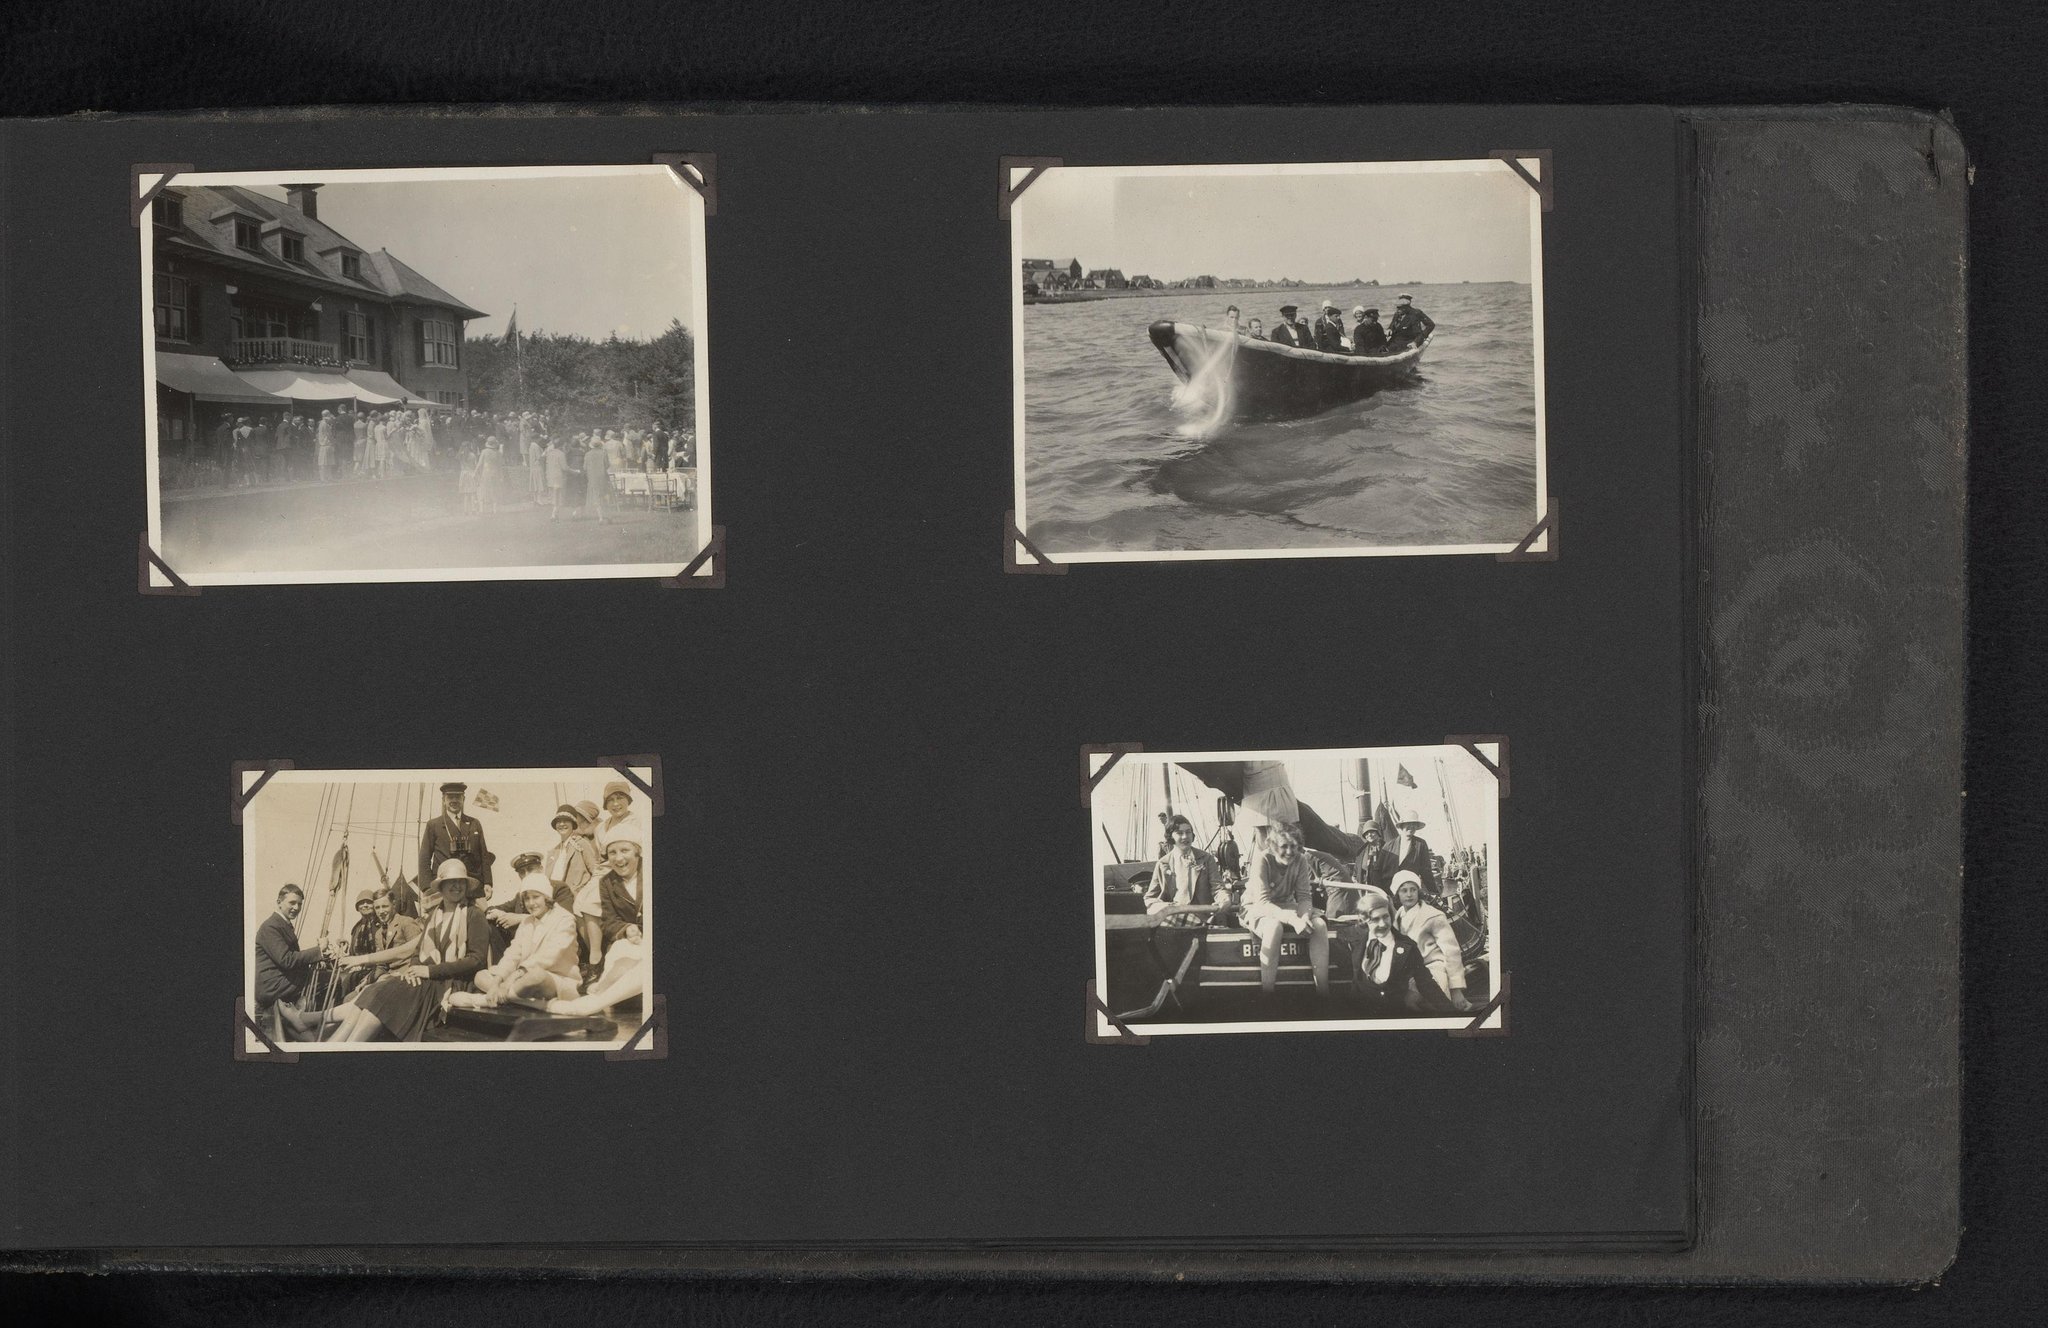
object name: album leaf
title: Vier foto's van feest bij landhuis De Hooght, Maarn, en een boottocht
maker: hendrik herman van den berg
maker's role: amateurfotograaf, jurist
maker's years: 1875-1944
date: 1929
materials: paper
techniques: gelatin silver print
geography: netherlands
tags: wedding feast, wedding meal, garden, crew and passengers ~ ship, netherlands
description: Deze foto's maken deel uit van een album.